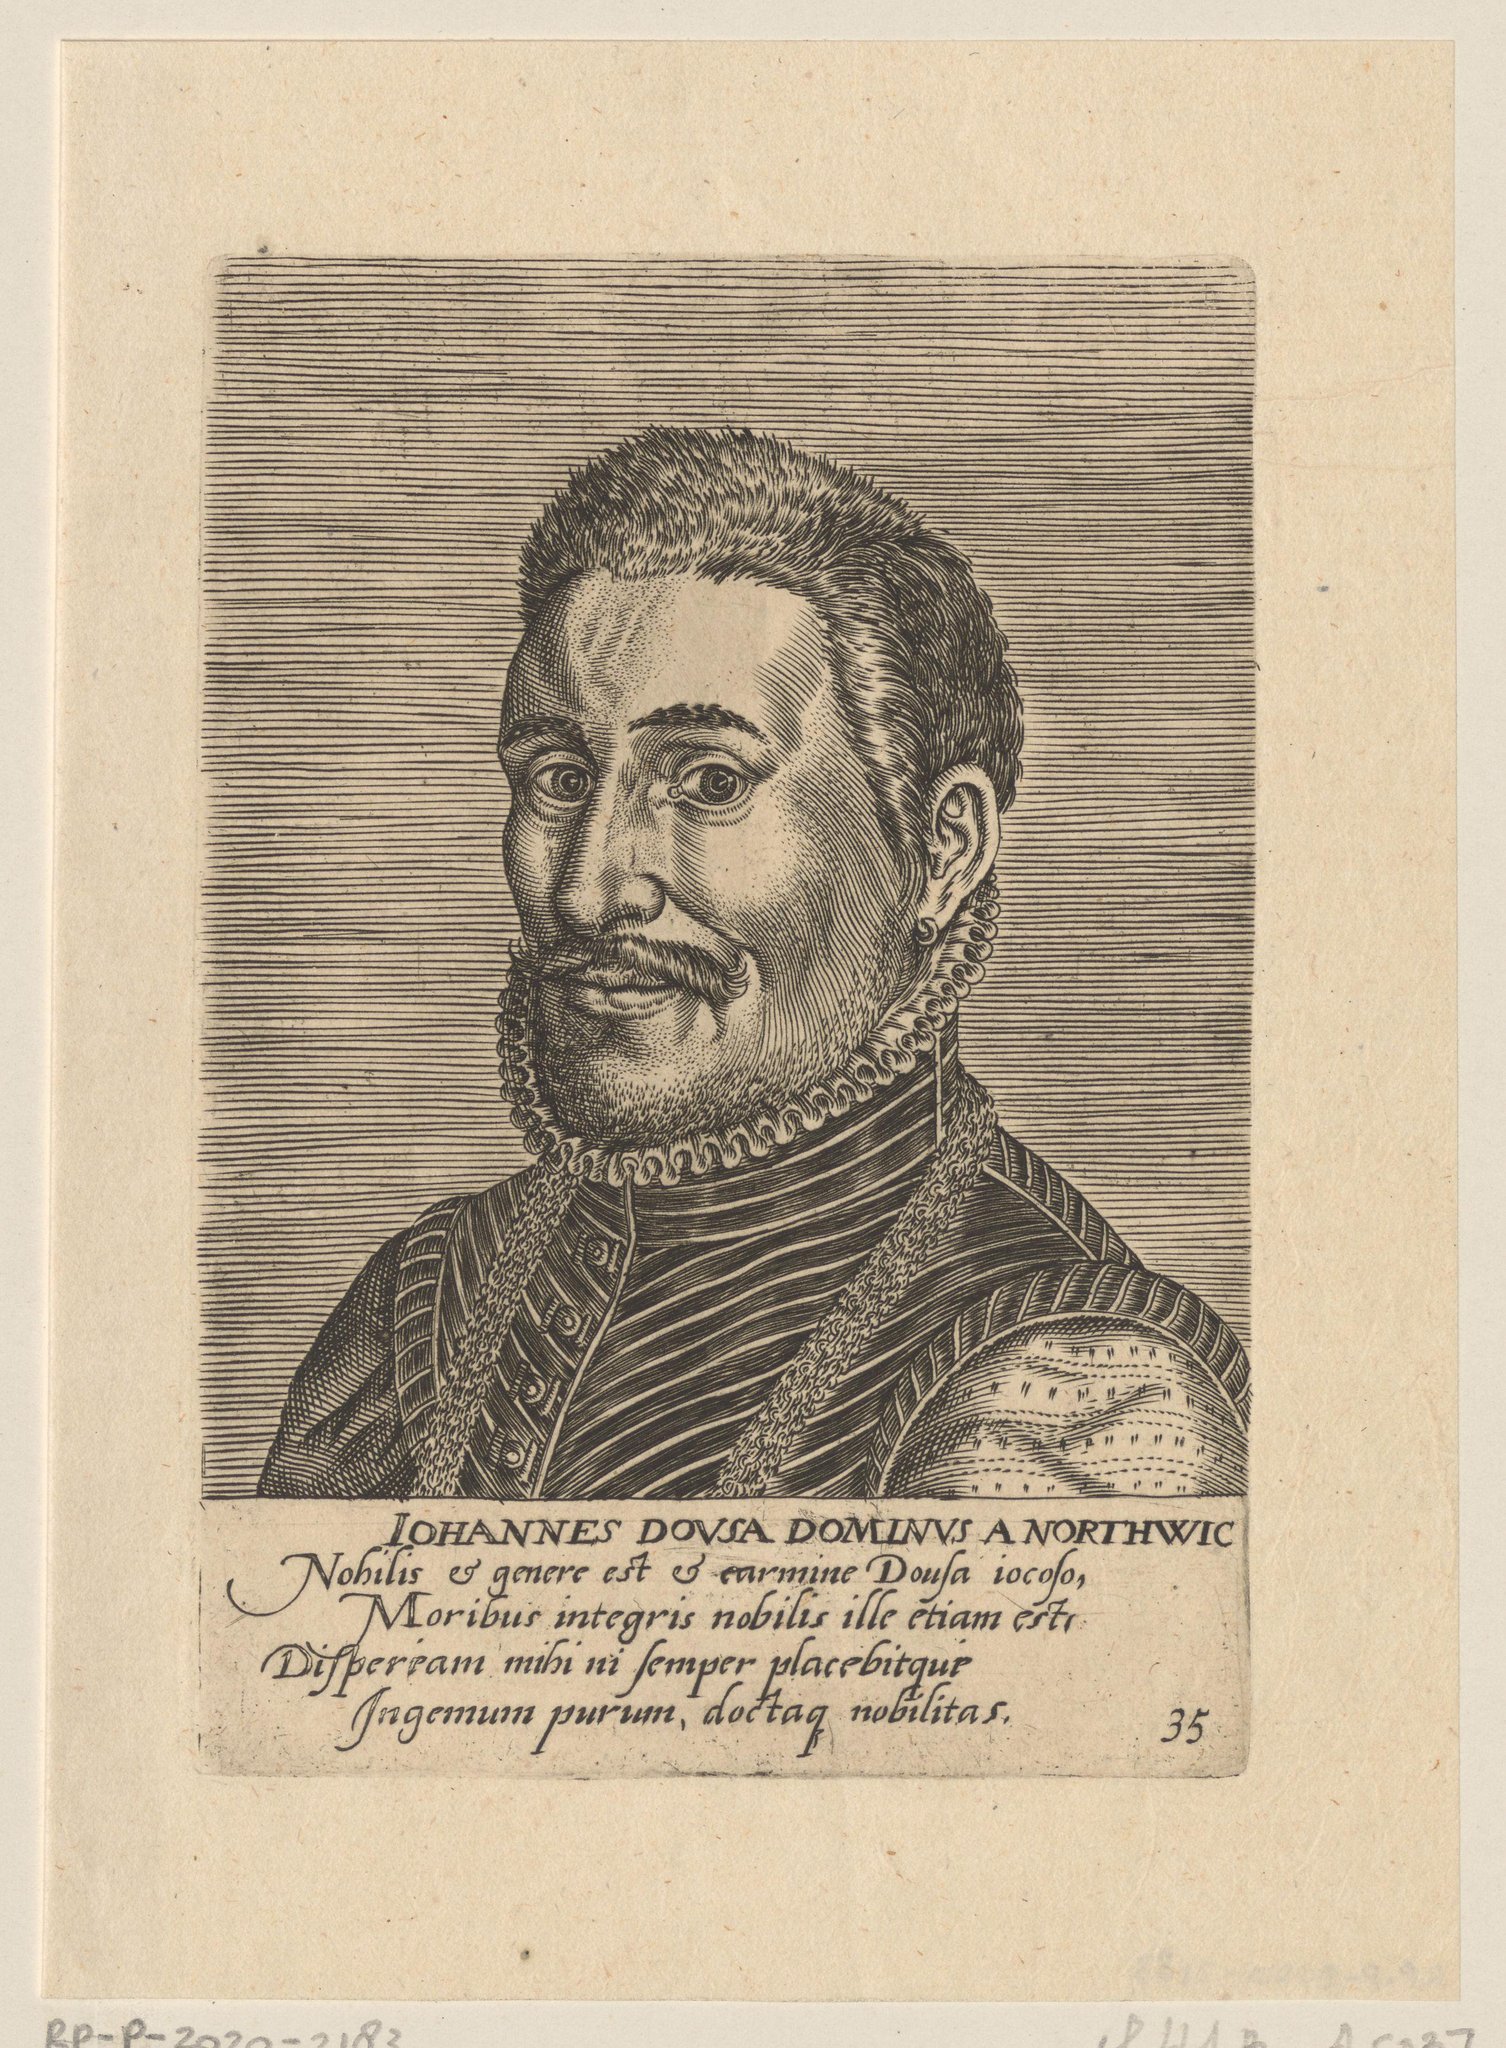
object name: print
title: Portret van Jan van der Does, heer van Noordwijk en Kattendijke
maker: Anonymous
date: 1572-1649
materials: paper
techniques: engraving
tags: commander-in-chief, general, marshal, historical persons, writer, poet, author